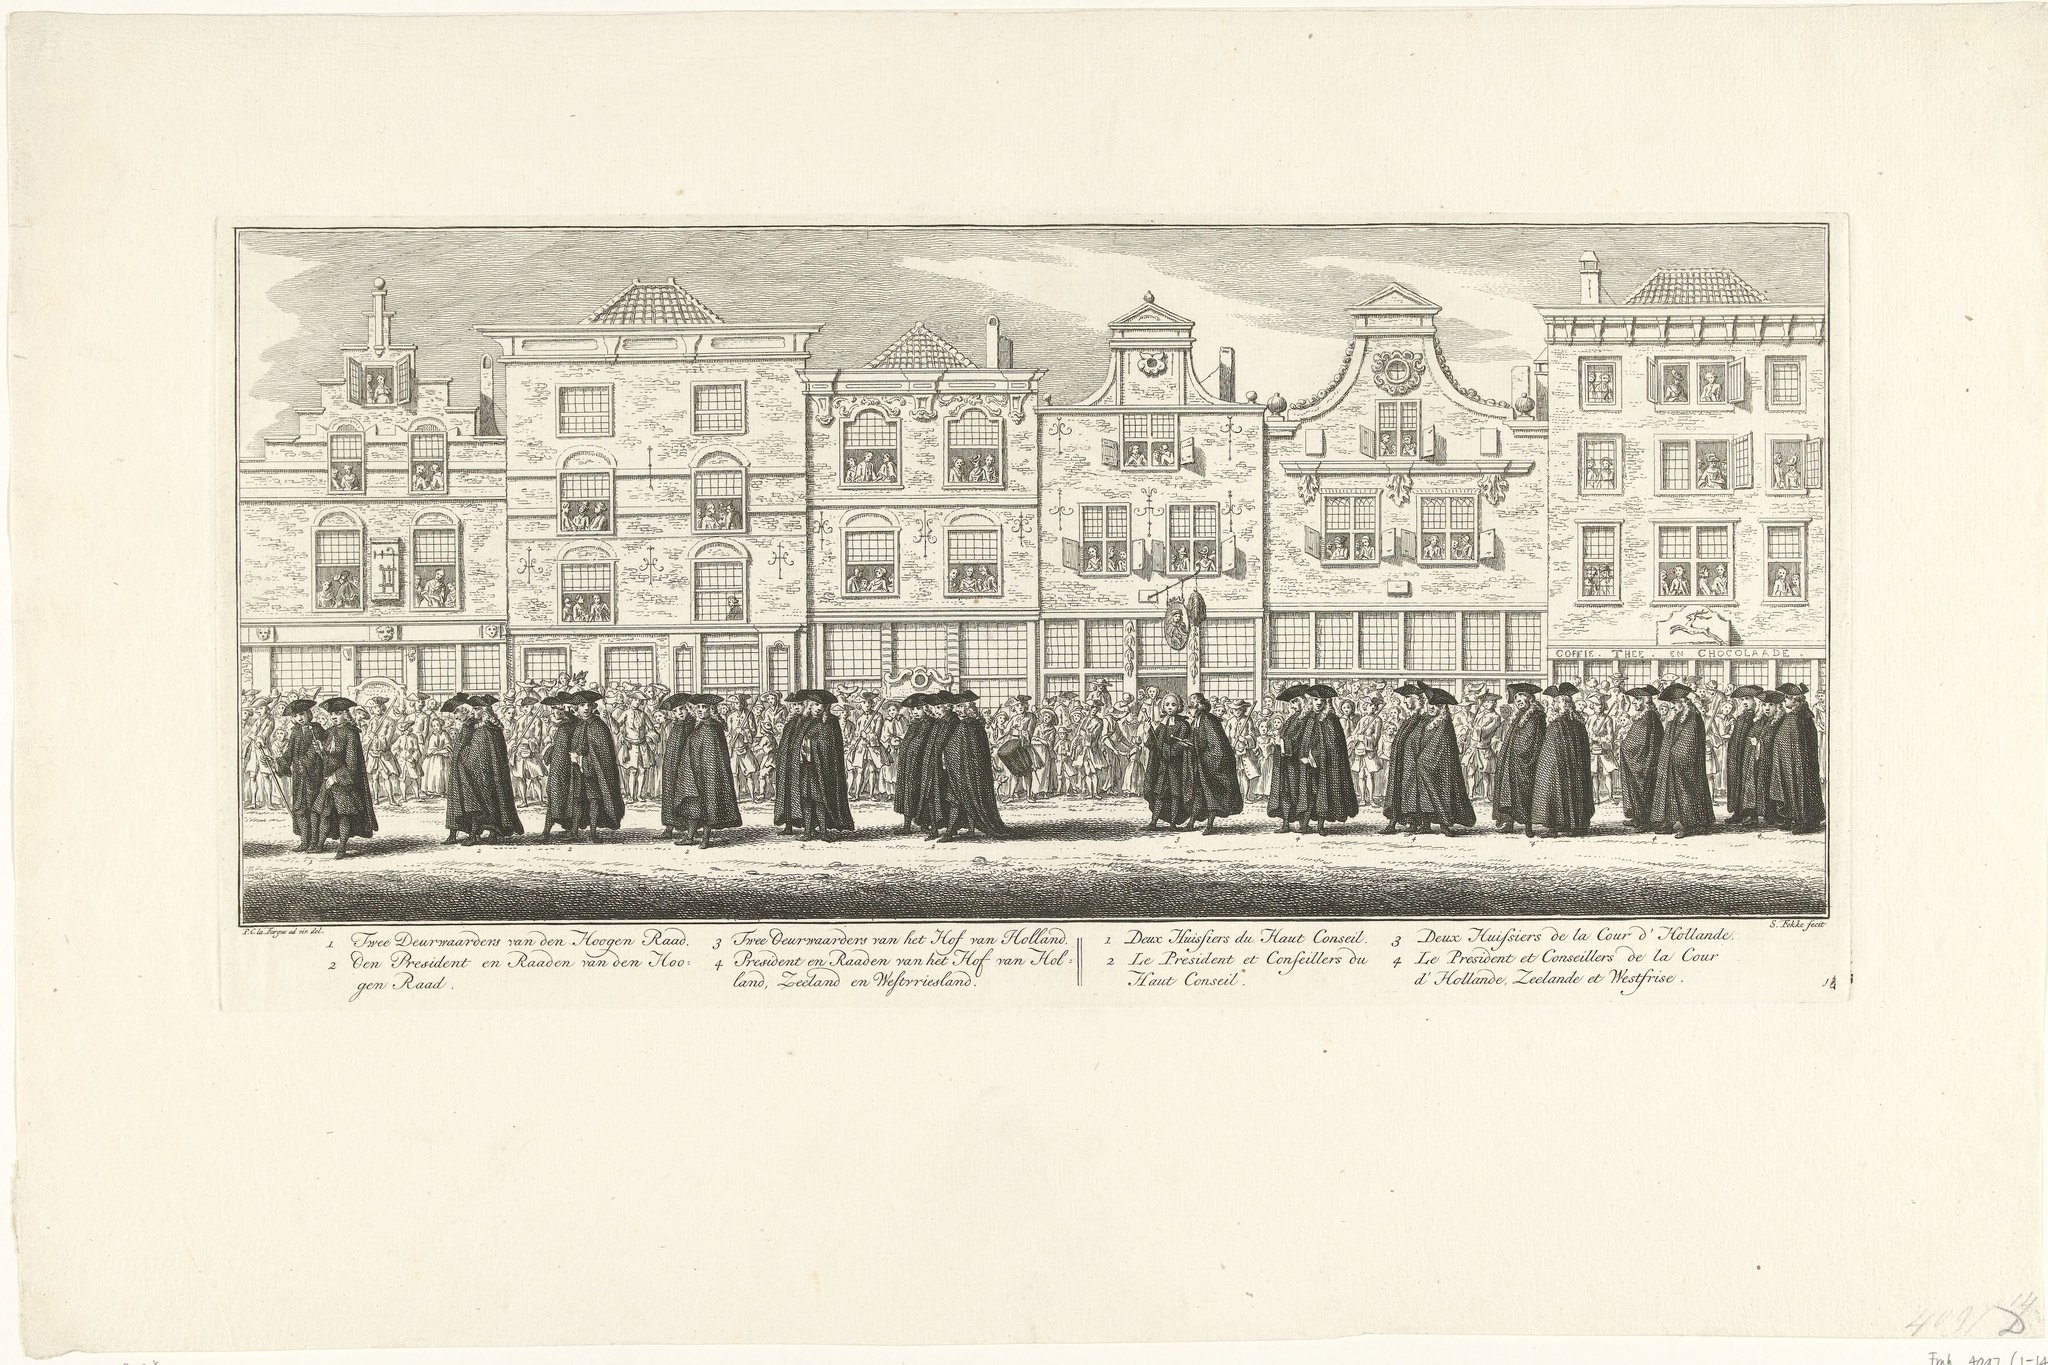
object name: print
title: Juridische staf in de lijkstoet van Anna van Hannover te Delft, 1759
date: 1759-1761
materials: paper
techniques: etching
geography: amsterdam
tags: the hague, anna van hannover, cortege, funeral procession, delft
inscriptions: serial number: ‘14’, collector's mark: Lugt 2228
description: Juridische staf te voet in de lijkstoet van Anna van Hannover, prinses van Oranje-Nassau, te Delft. De figuren in de stoet zijn genummerd en onder de voorstelling nader omschreven. Het serienummer is rechtsonder met pen verbeterd.